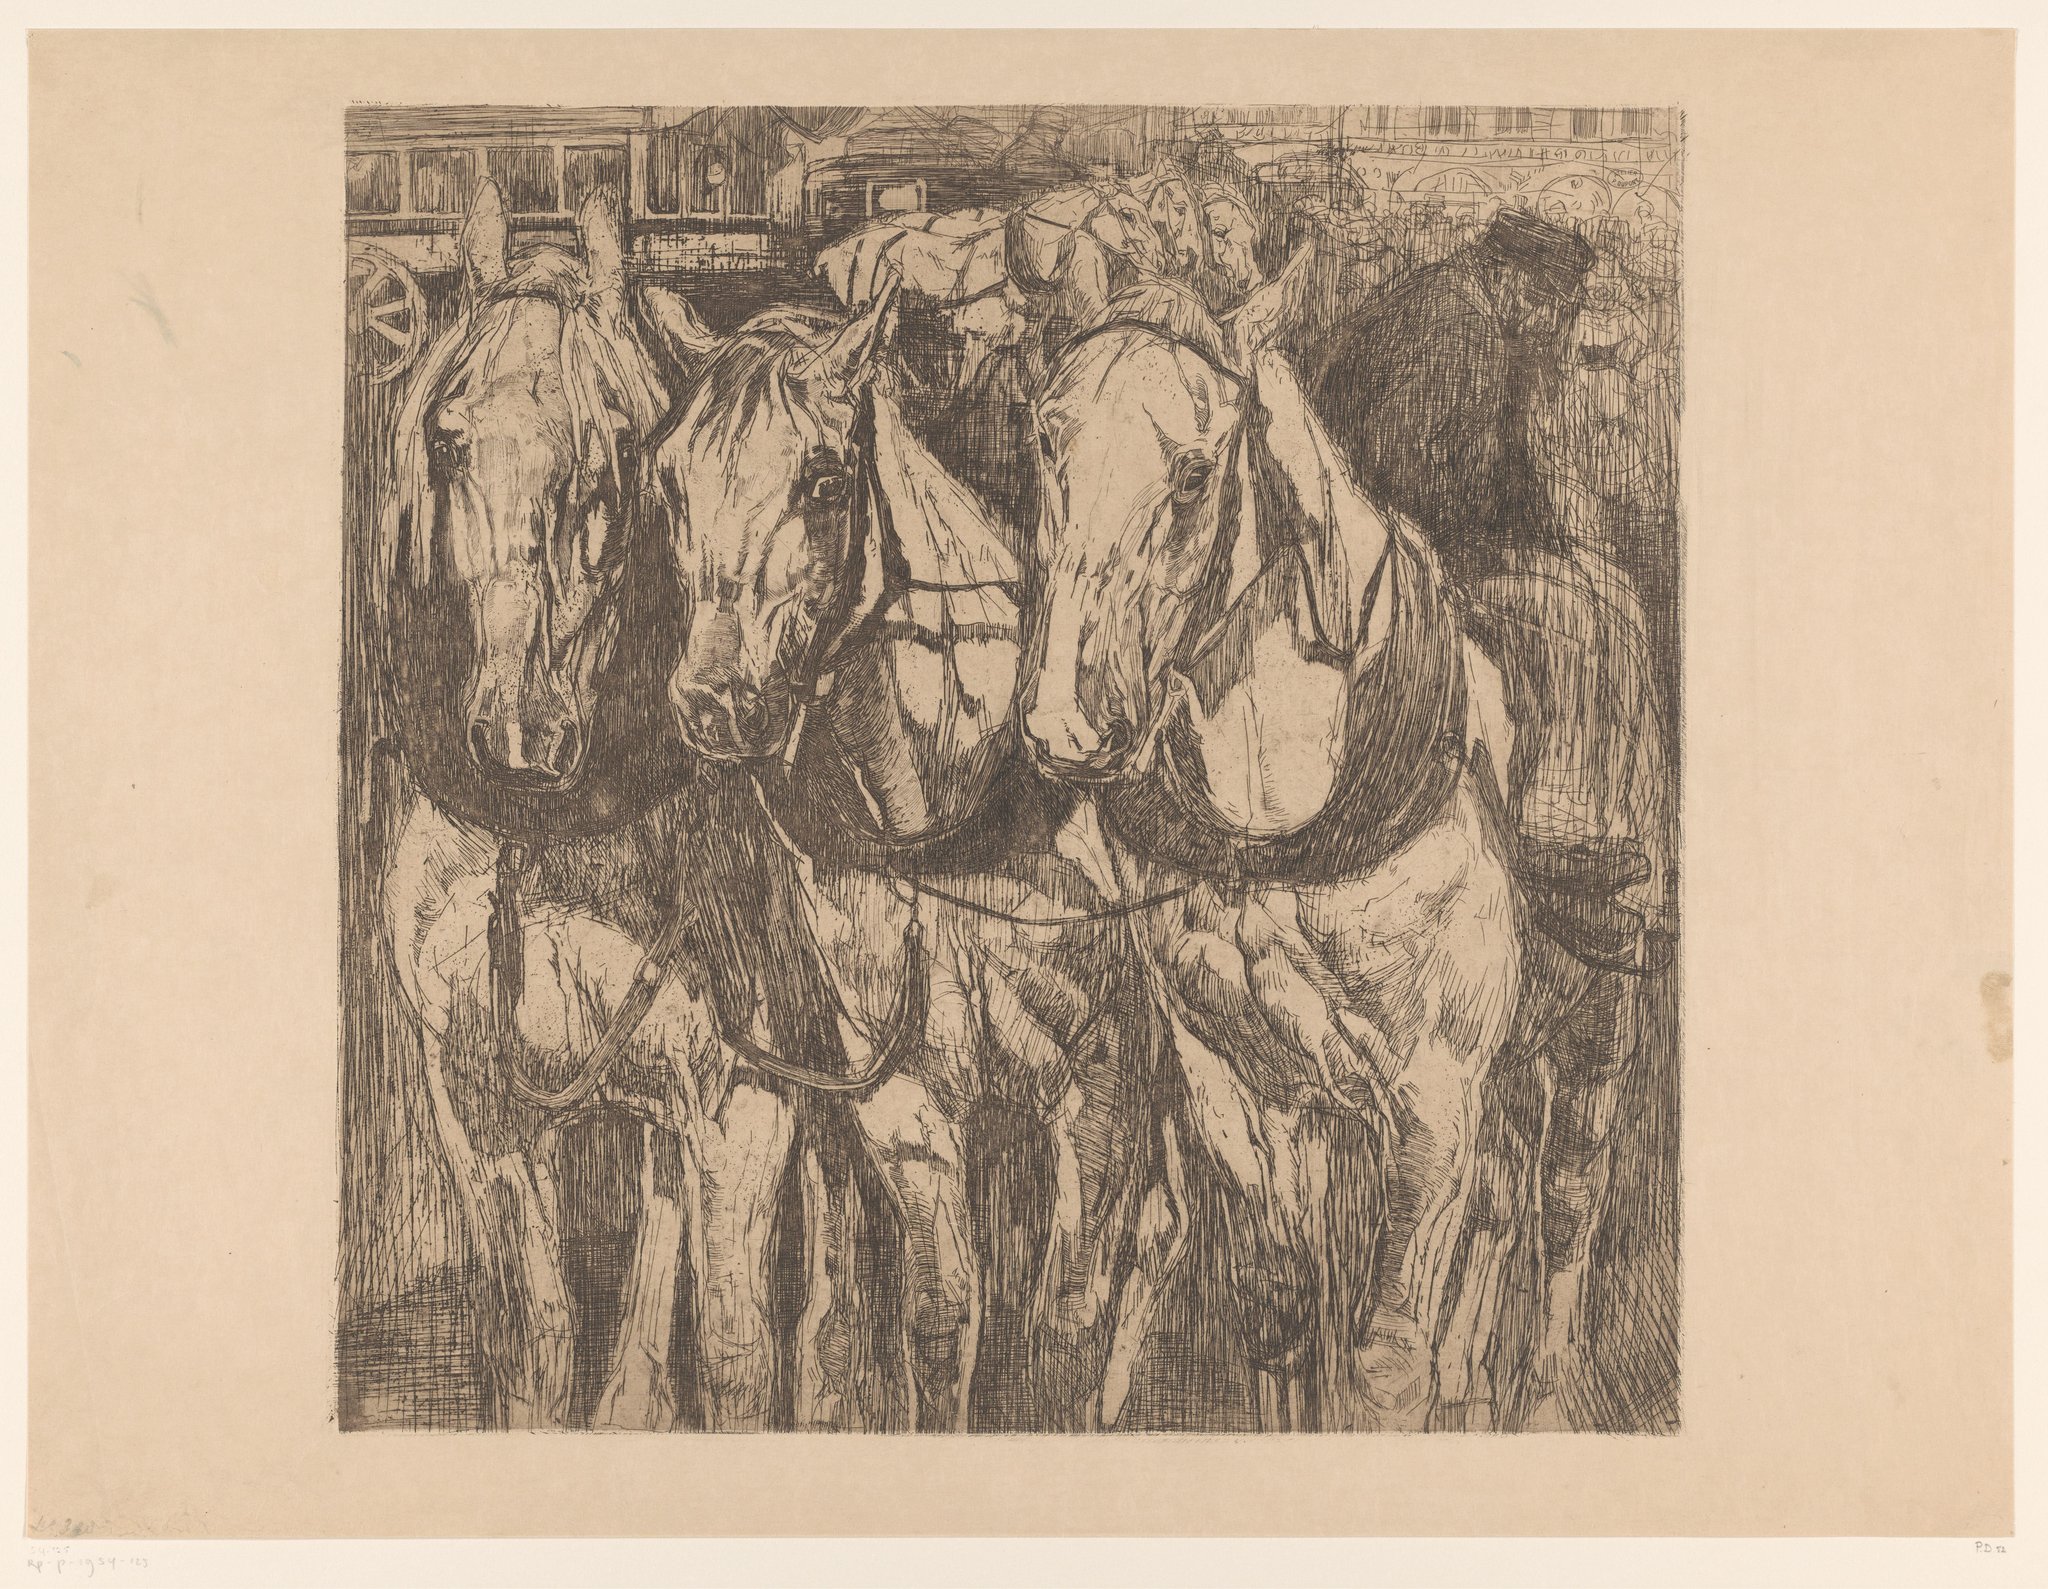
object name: print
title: Drie trekpaarden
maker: pieter dupont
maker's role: draughtsman, print maker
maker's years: 1870-1911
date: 1896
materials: paper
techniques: etching, intaglio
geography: paris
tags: horse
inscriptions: collector's mark: Lugt 2228